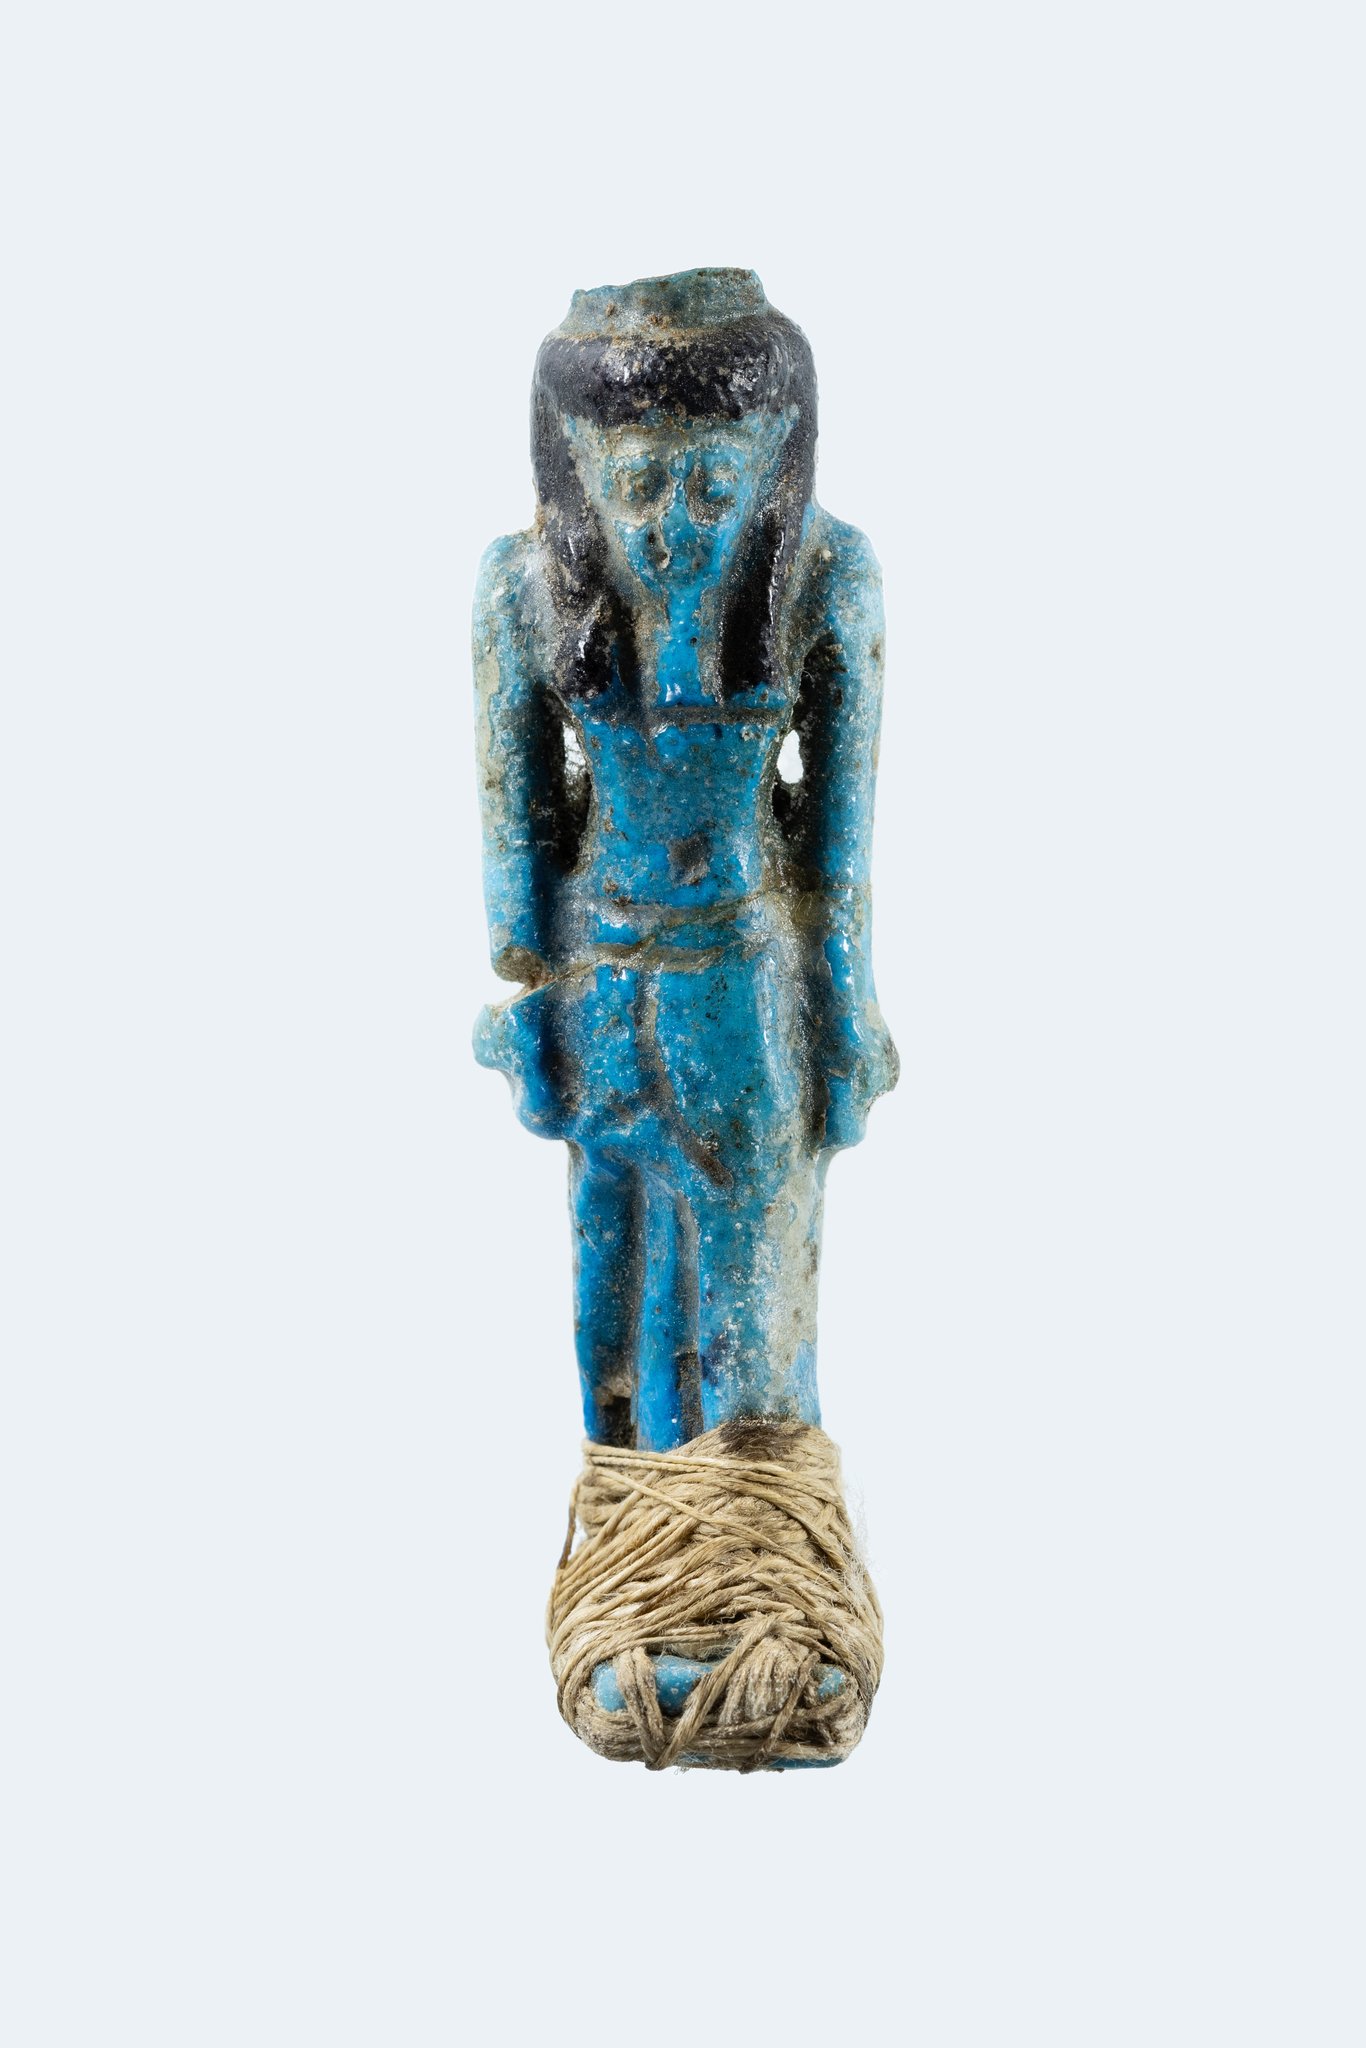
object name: amulet, nefertum, broken foot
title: Nefertum amulet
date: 1070-525 BCE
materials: faience, thread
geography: egypt